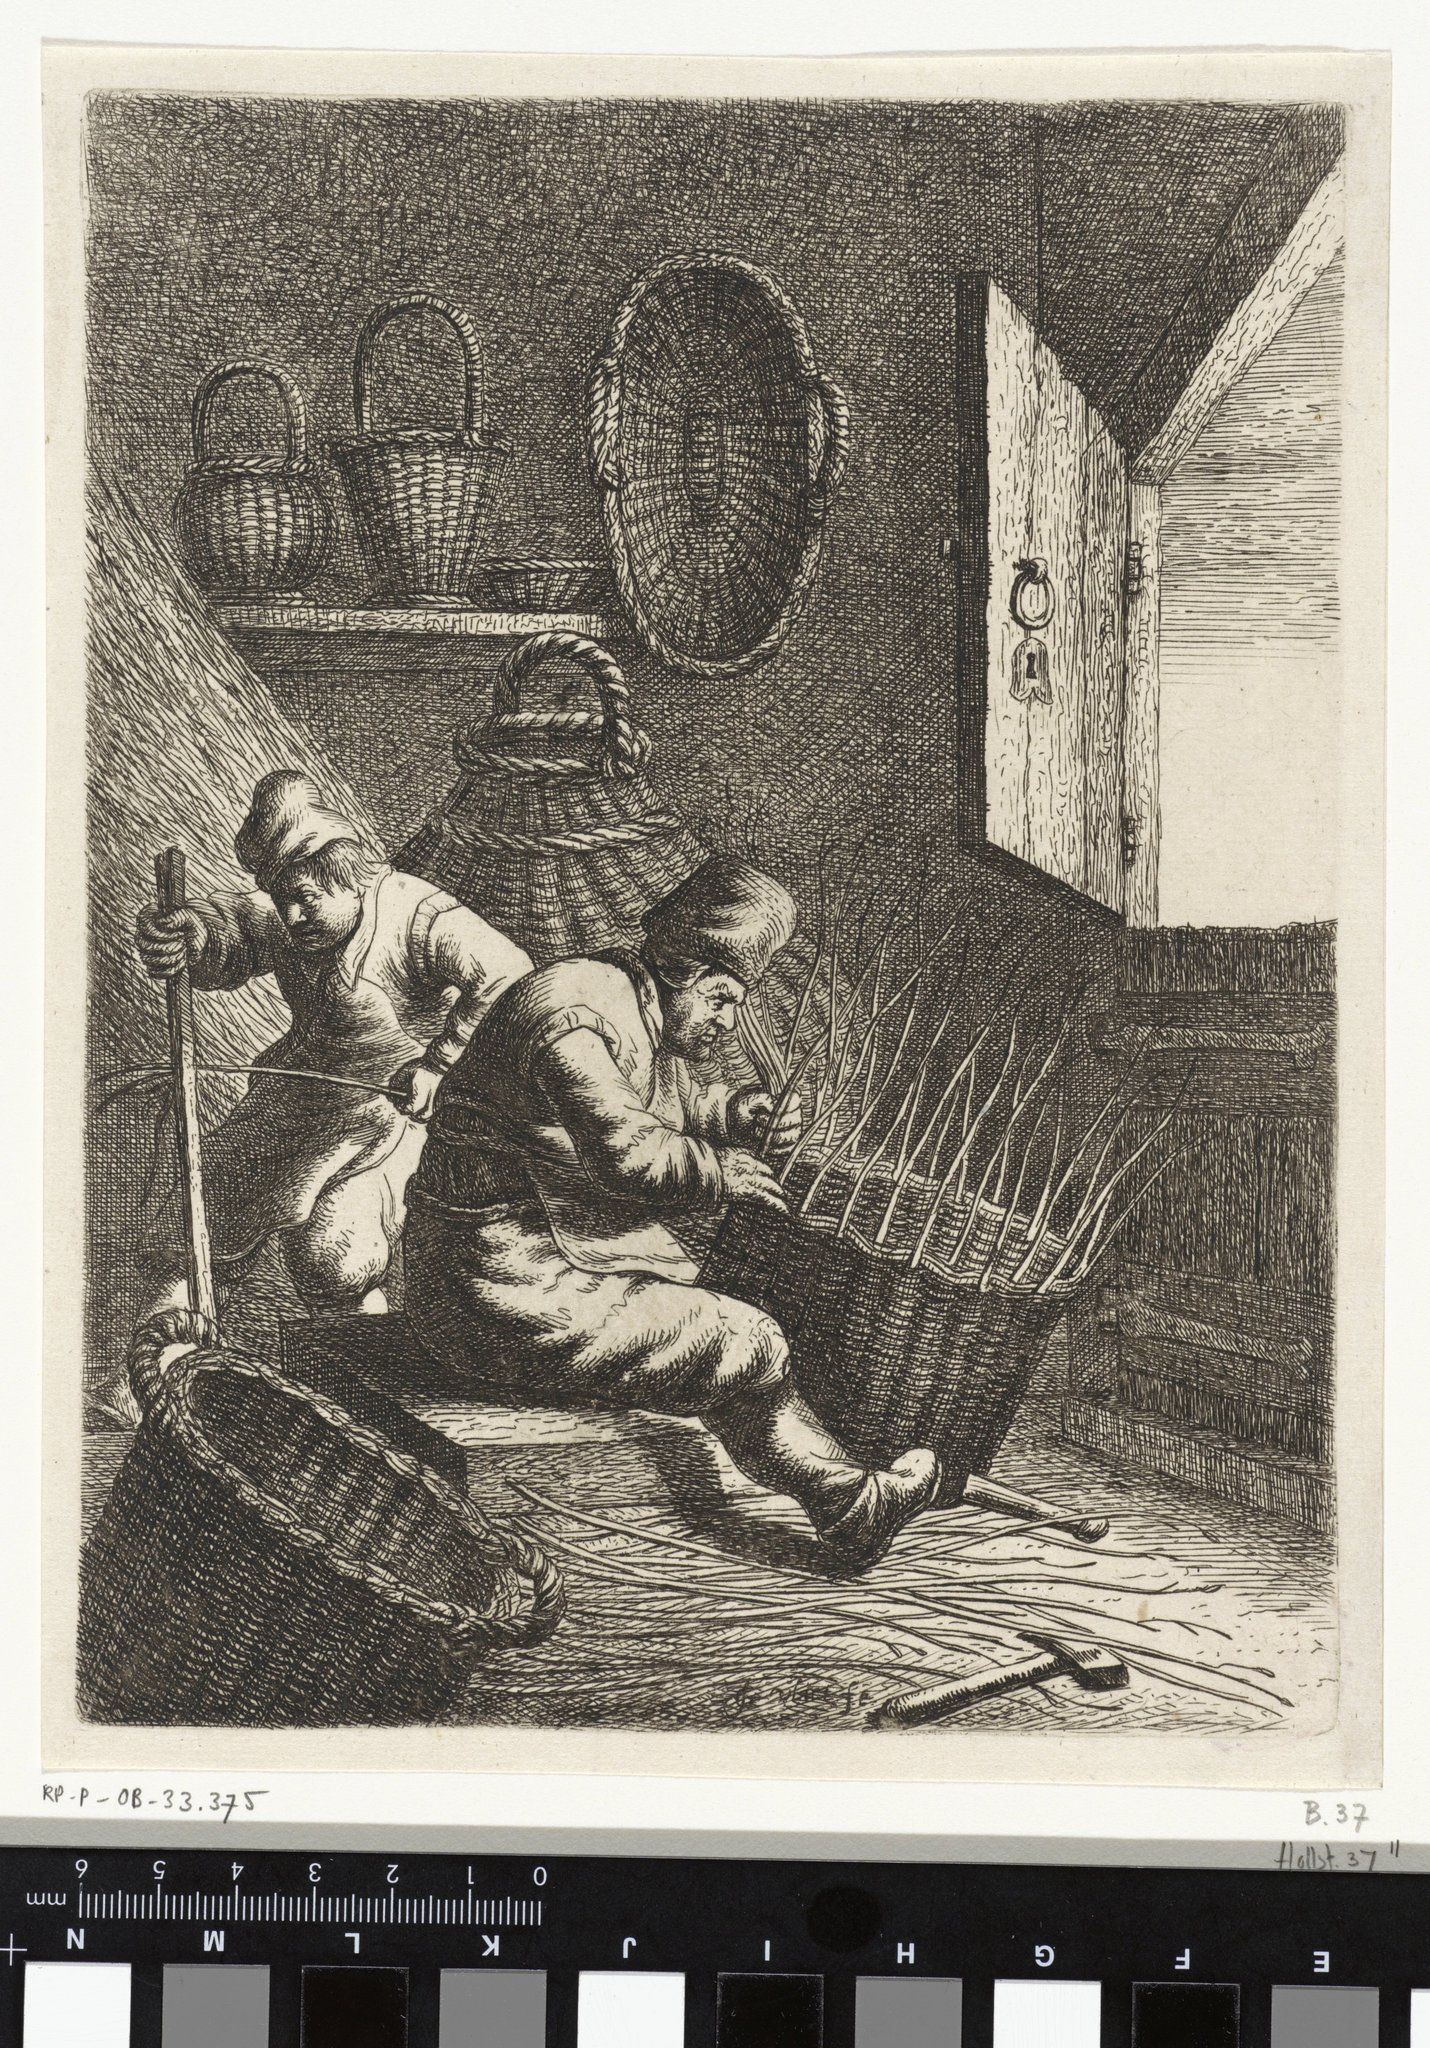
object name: print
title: Beroepen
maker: jan gillisz. van vliet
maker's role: draughtsman, painter, print maker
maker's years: 1600-1668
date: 1635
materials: paper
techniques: etching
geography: leiden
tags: container made of plant material other than wood: basket, divided door, upper part opened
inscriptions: collector's mark: Lugt 240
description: Twee mandenmakers vlechten manden in een interieur met een openstaande bovendeur.